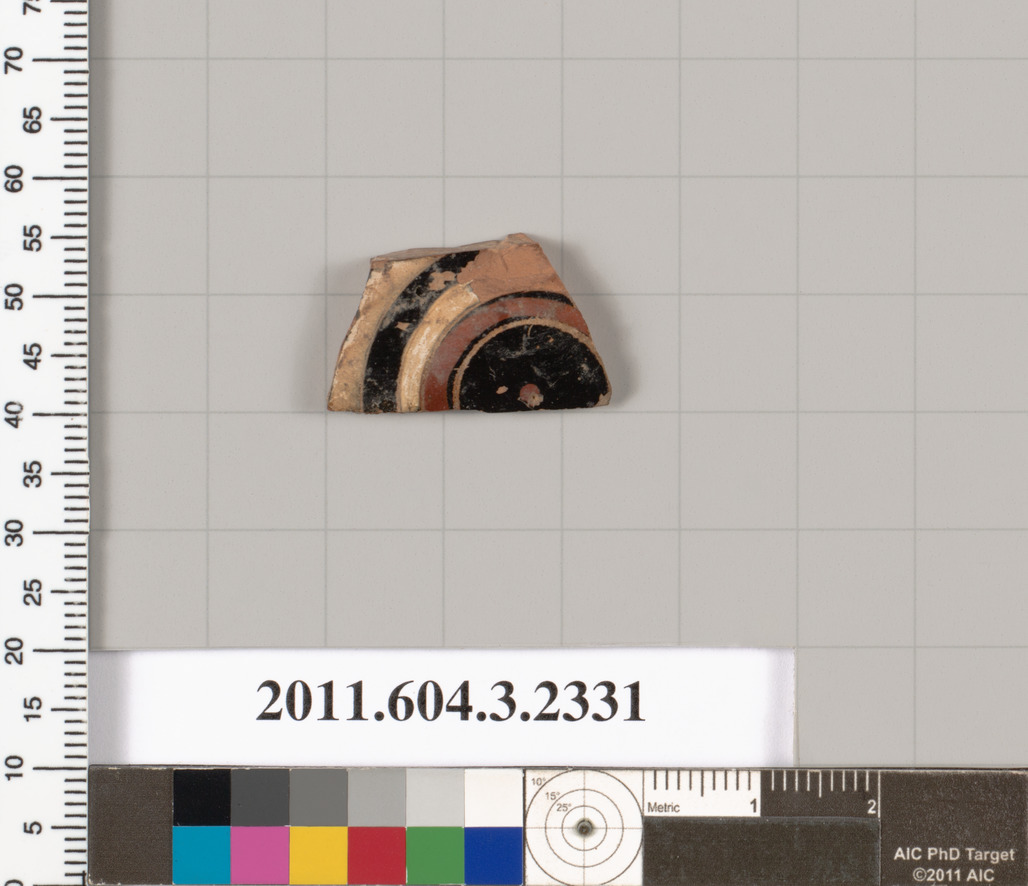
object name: kylix fragment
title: Terracotta fragment of a kylix: eye-cup (drinking cup)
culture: greek, attic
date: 540-520 BCE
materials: terracotta